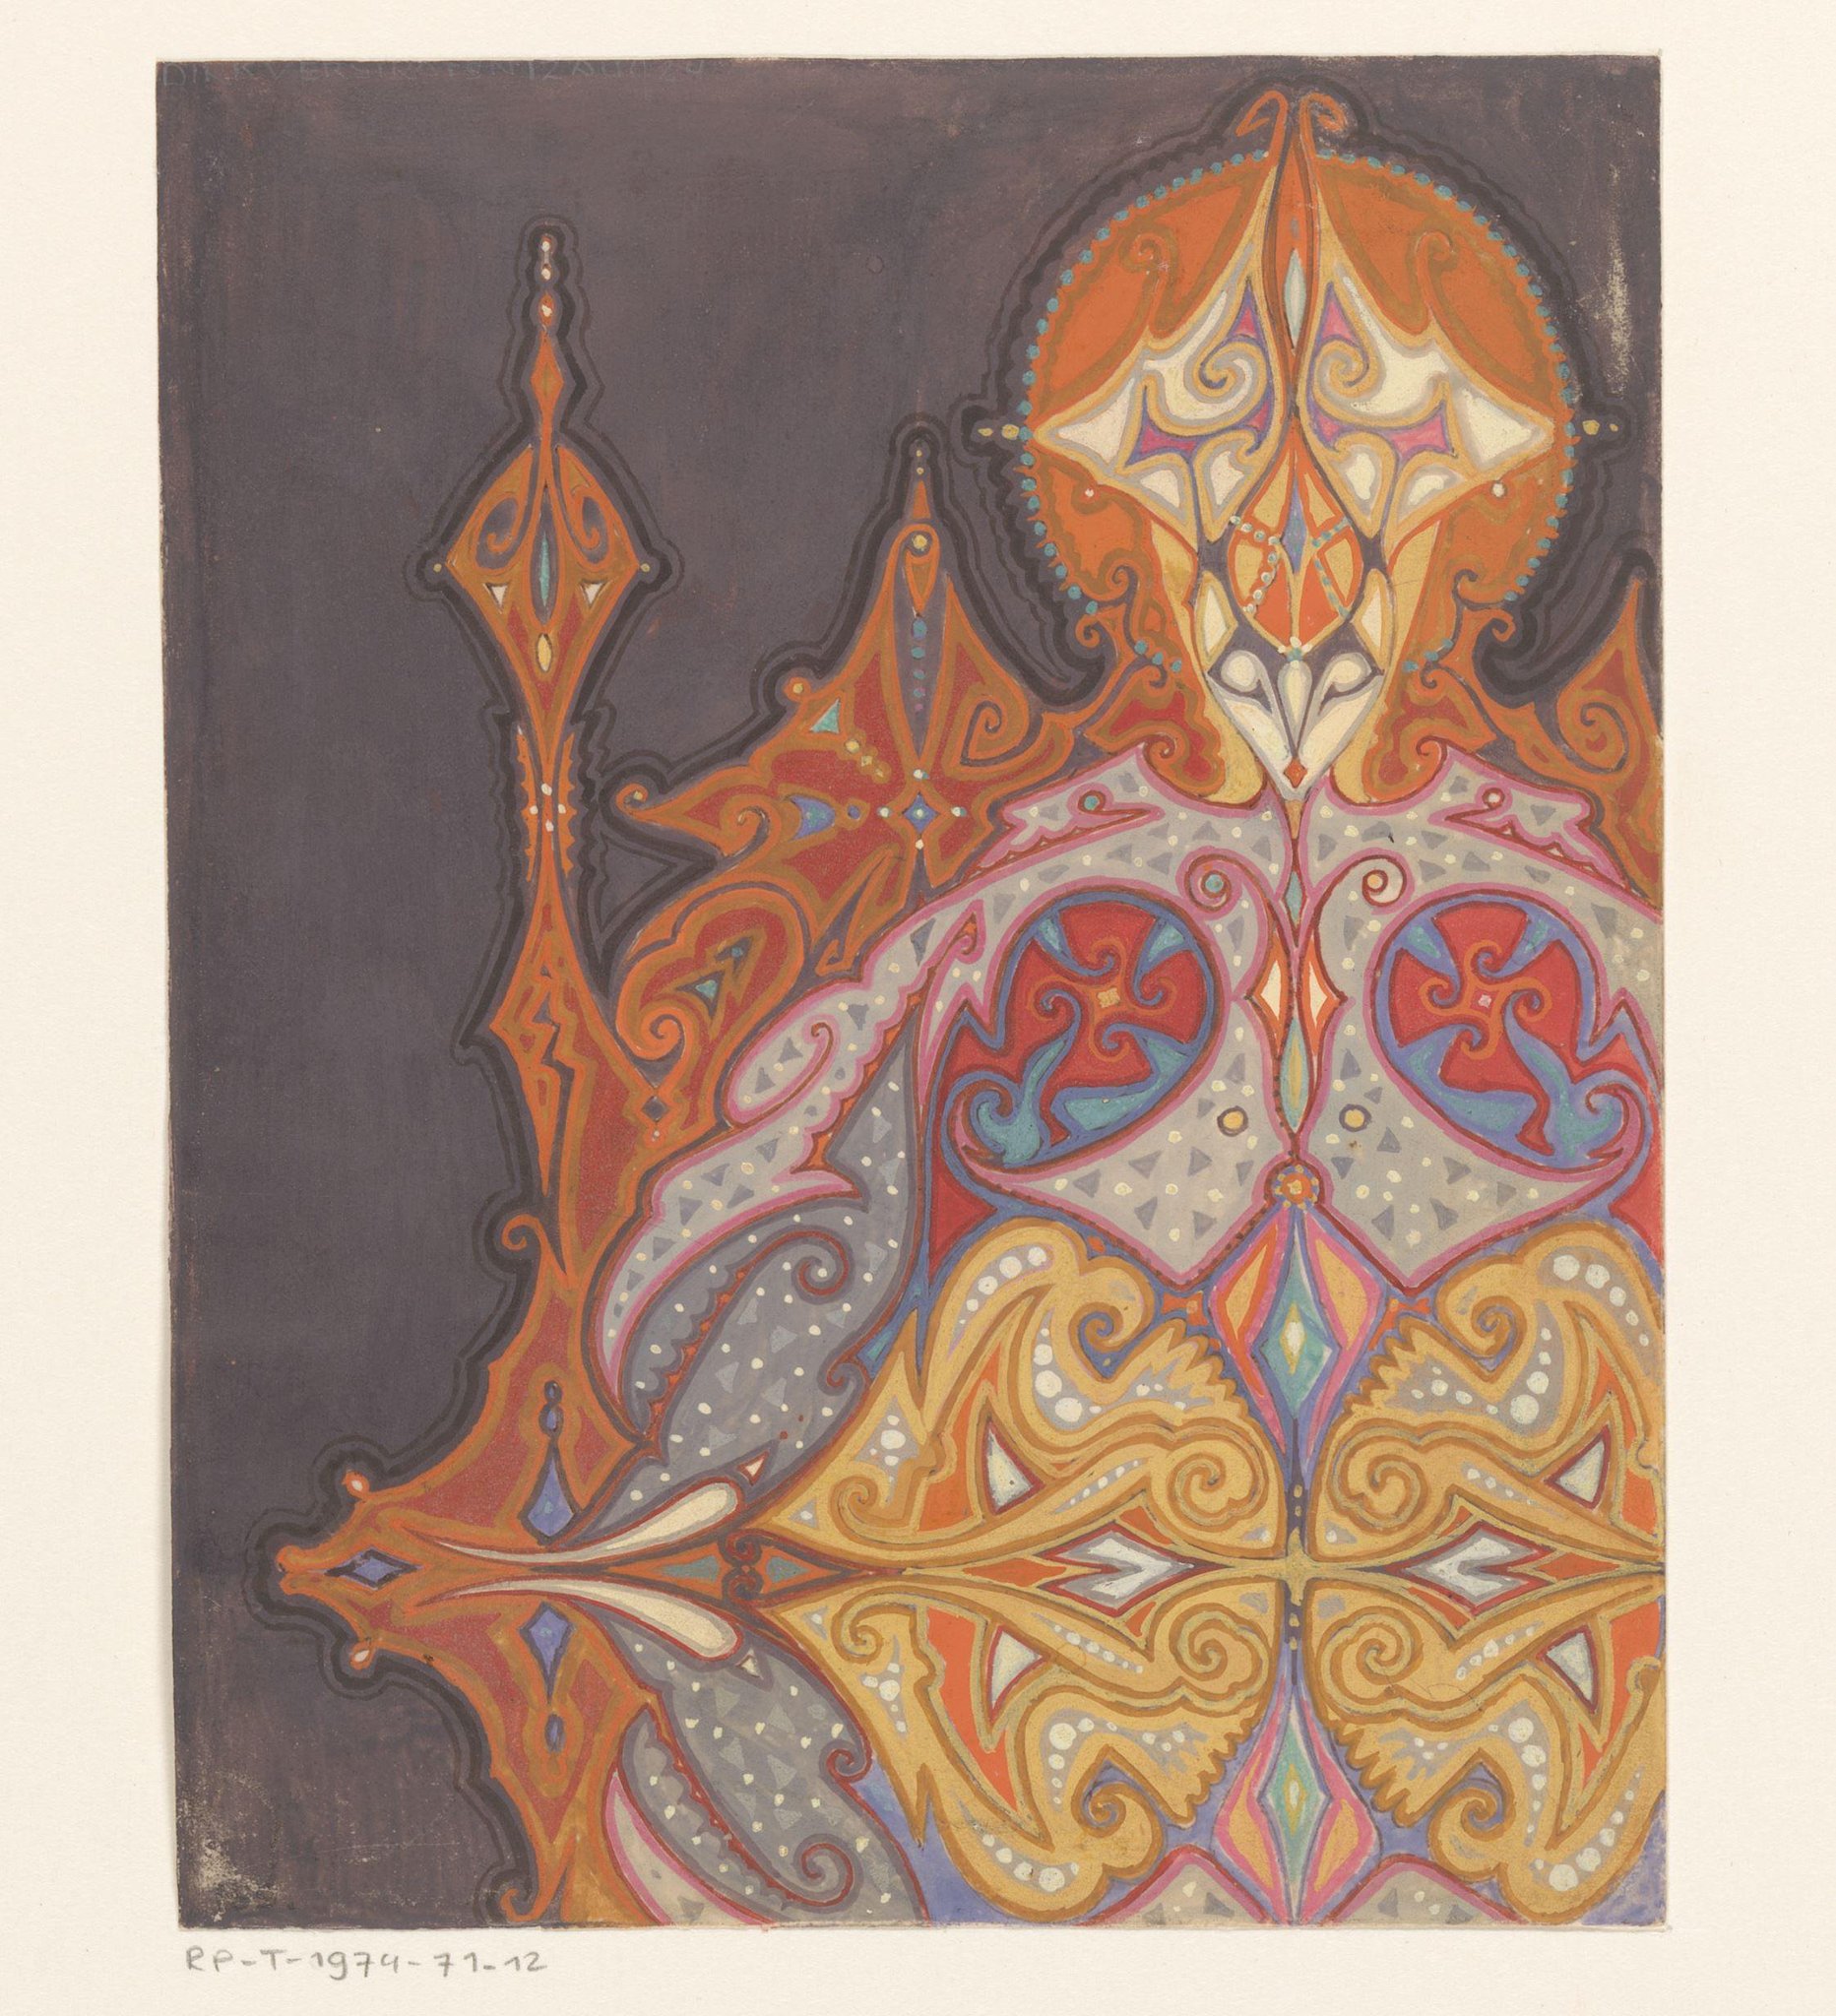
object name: drawing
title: Ontwerp voor een tapijt met een fantasiefiguur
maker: dirk verstraten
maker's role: designer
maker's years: 1892-1946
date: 1920-1930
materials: paint, paper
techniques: brush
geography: amsterdam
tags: fantasy ornament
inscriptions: collector's mark: ‘R:MVS’, inscription: ‘BOEDHA’